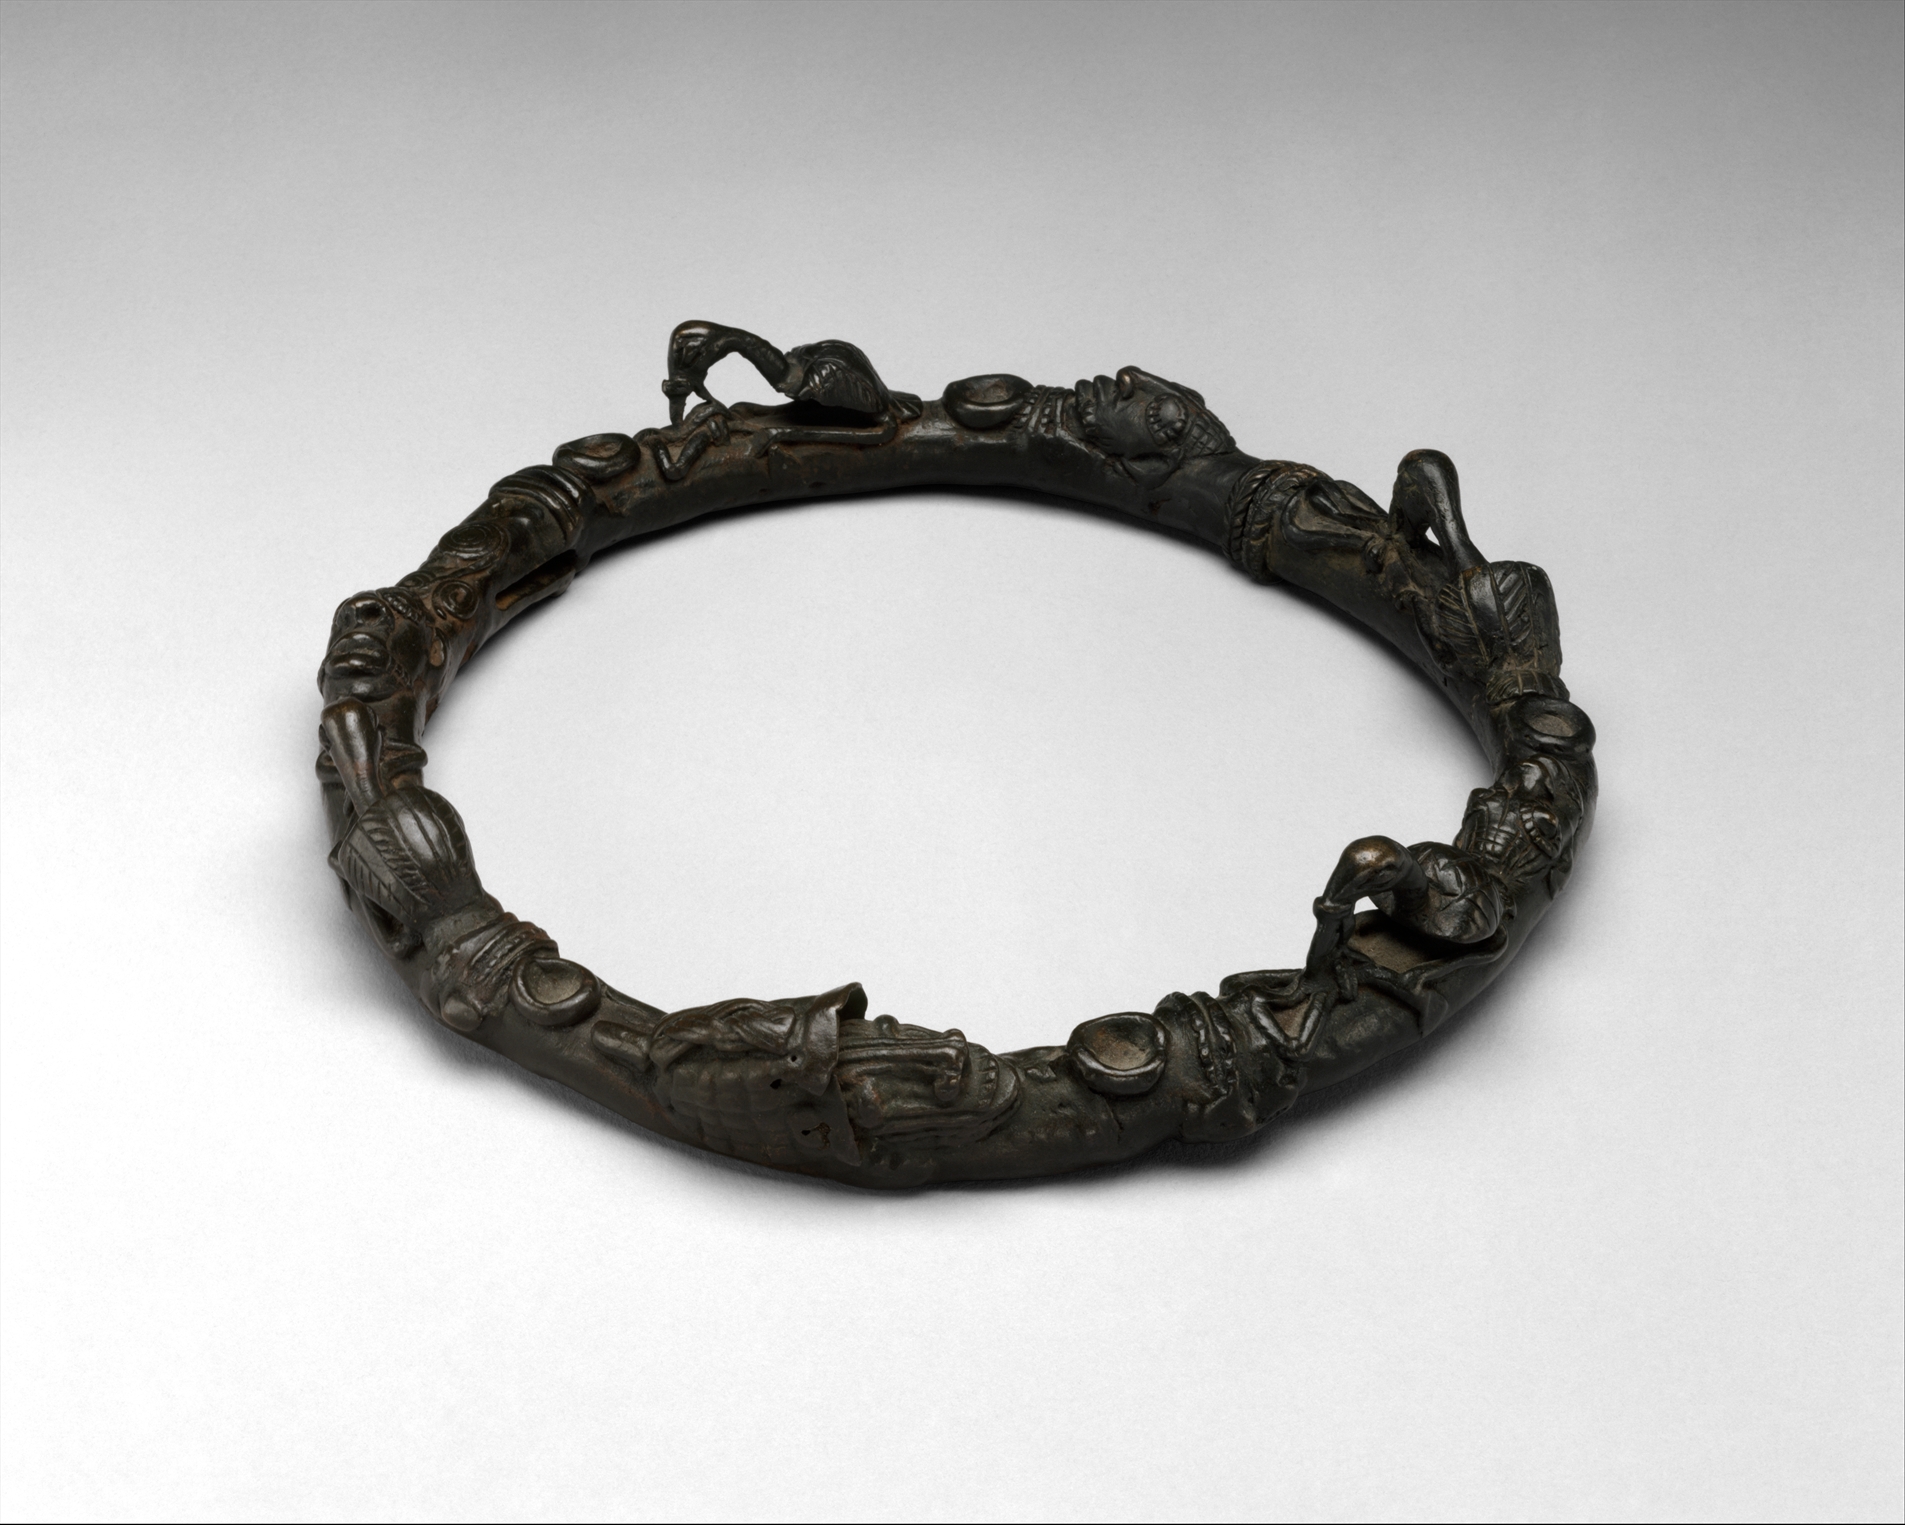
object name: altar ring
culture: edo period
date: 1601-1900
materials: brass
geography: nigeria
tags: birds